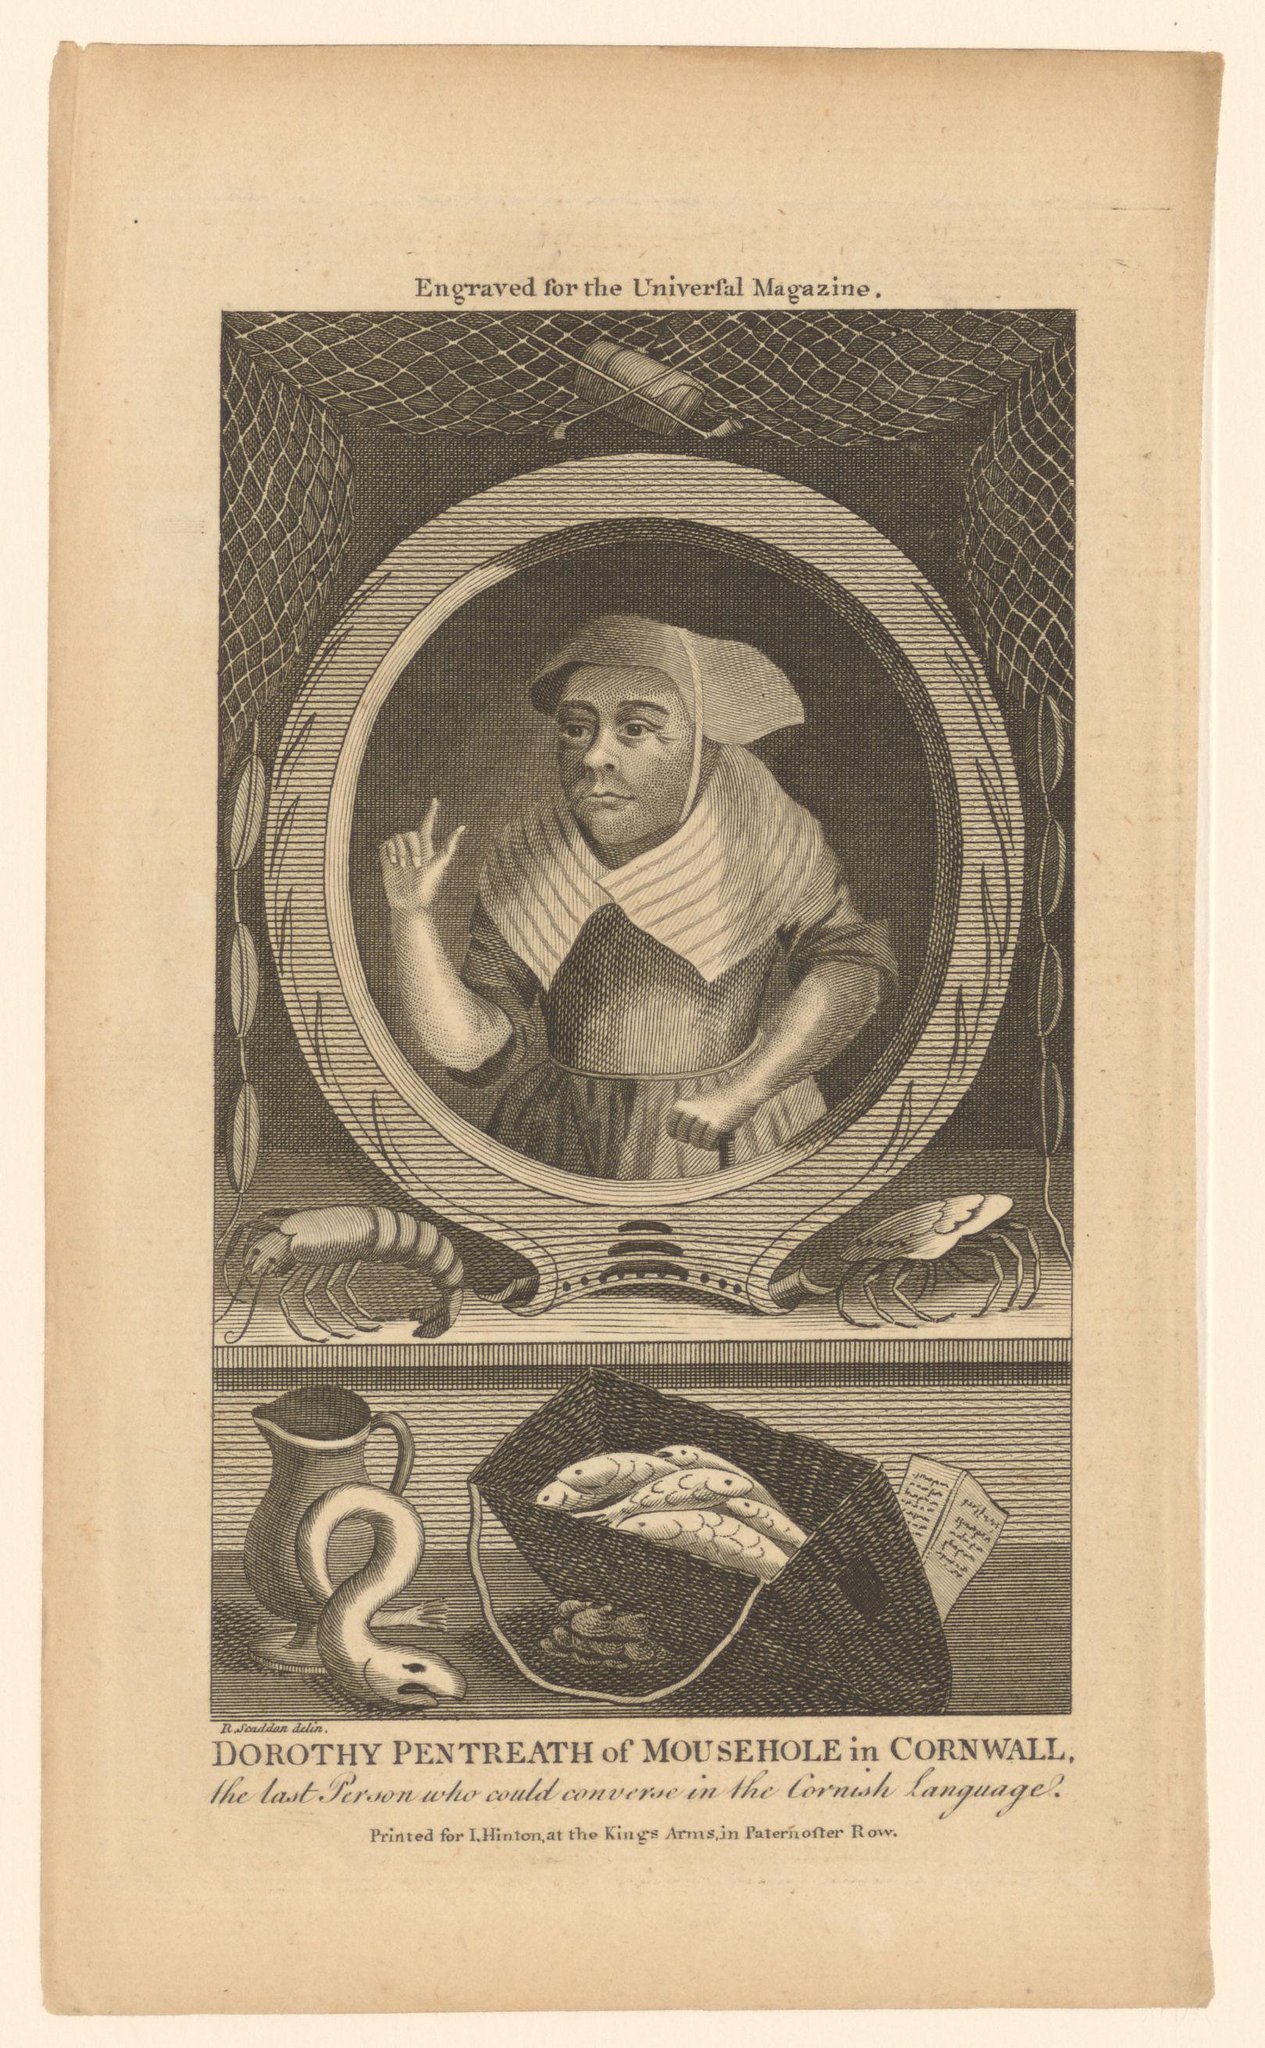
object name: print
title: Dorothy Pentreath of Mousehole in Cornwall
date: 1781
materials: paper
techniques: engraving, etching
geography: london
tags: historical persons, fishes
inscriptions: collector's mark: Lugt 2228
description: Prent gebruikt in: Universal Magazine, 1781.